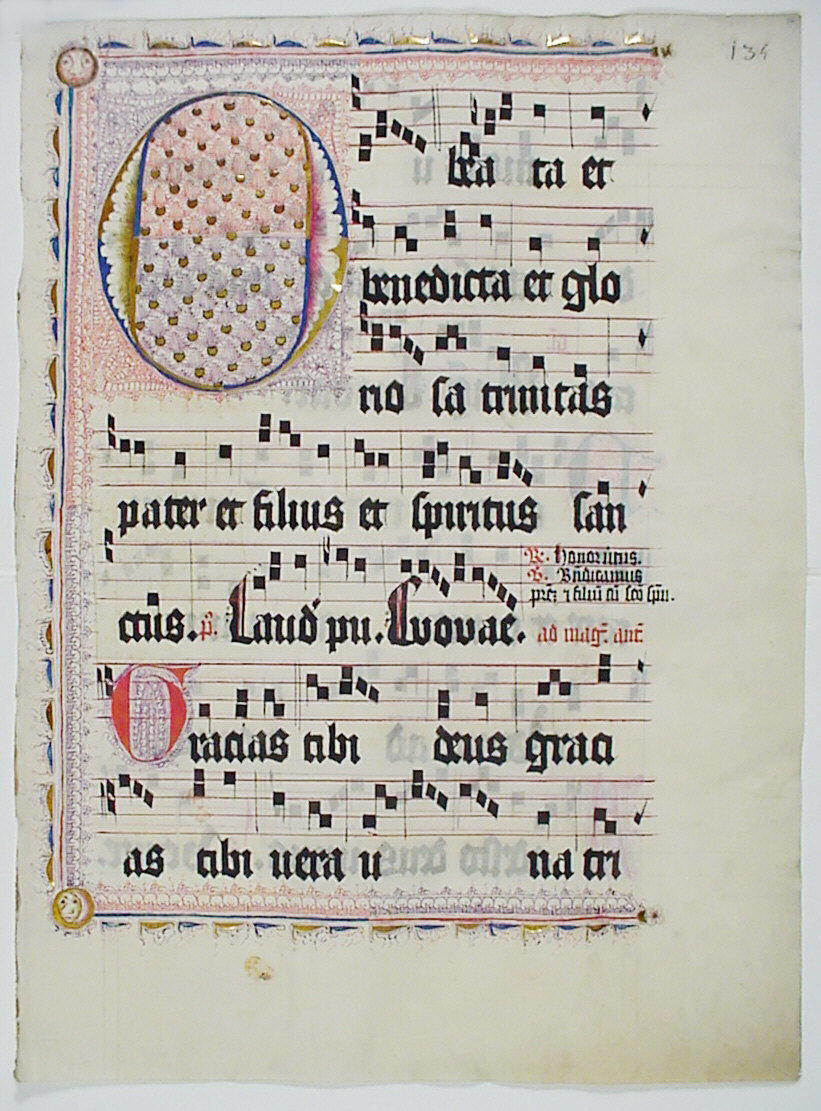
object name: antiphonary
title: Manuscript Leaf with Initial O, from an Antiphonary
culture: german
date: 1426-1450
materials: ink, metal leaf, parchment, paint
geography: germany